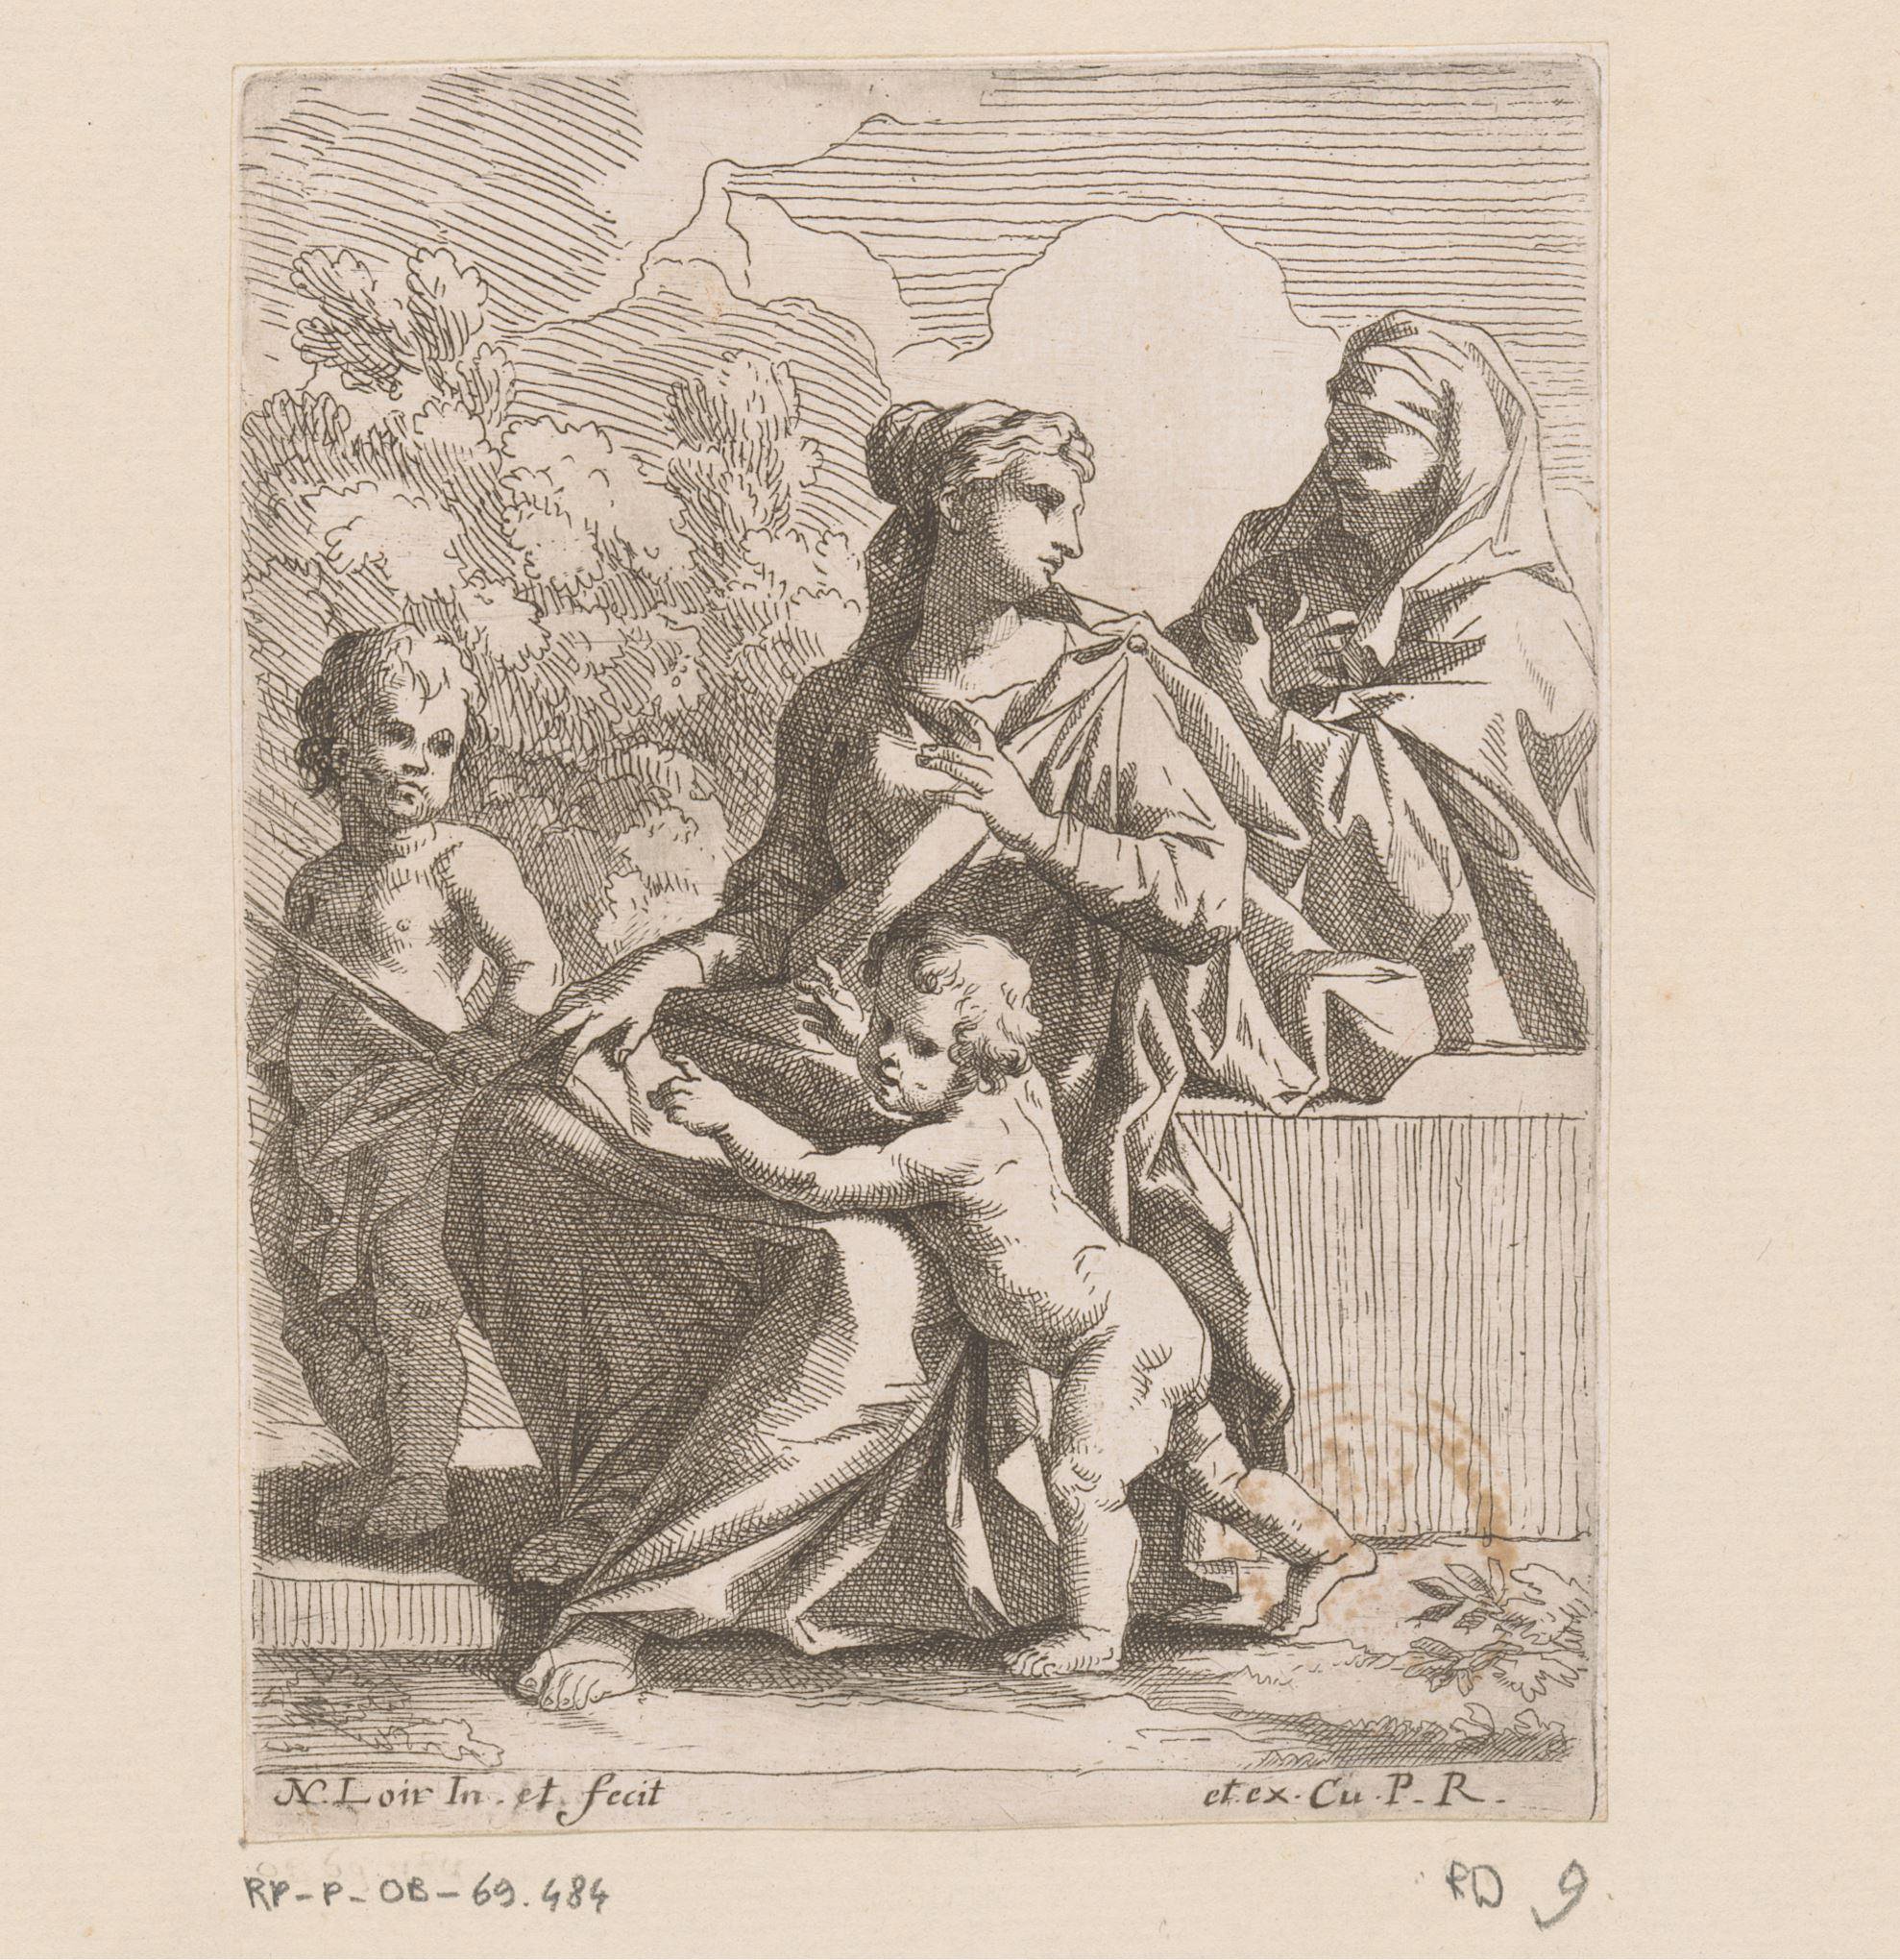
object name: print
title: Maria met Kind, Johannes en Elisabeth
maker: nicolas pierre loir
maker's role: painter, print maker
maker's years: 1624-1679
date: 1634-1679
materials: paper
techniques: etching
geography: france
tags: mary, the christ-child and john the baptist, elisabeth present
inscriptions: collector's mark: Lugt 240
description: Maakt deel uit van een twaalfdelige serie met Heilige families en afbeeldingen van Maria met kind en Johannes de Doper.